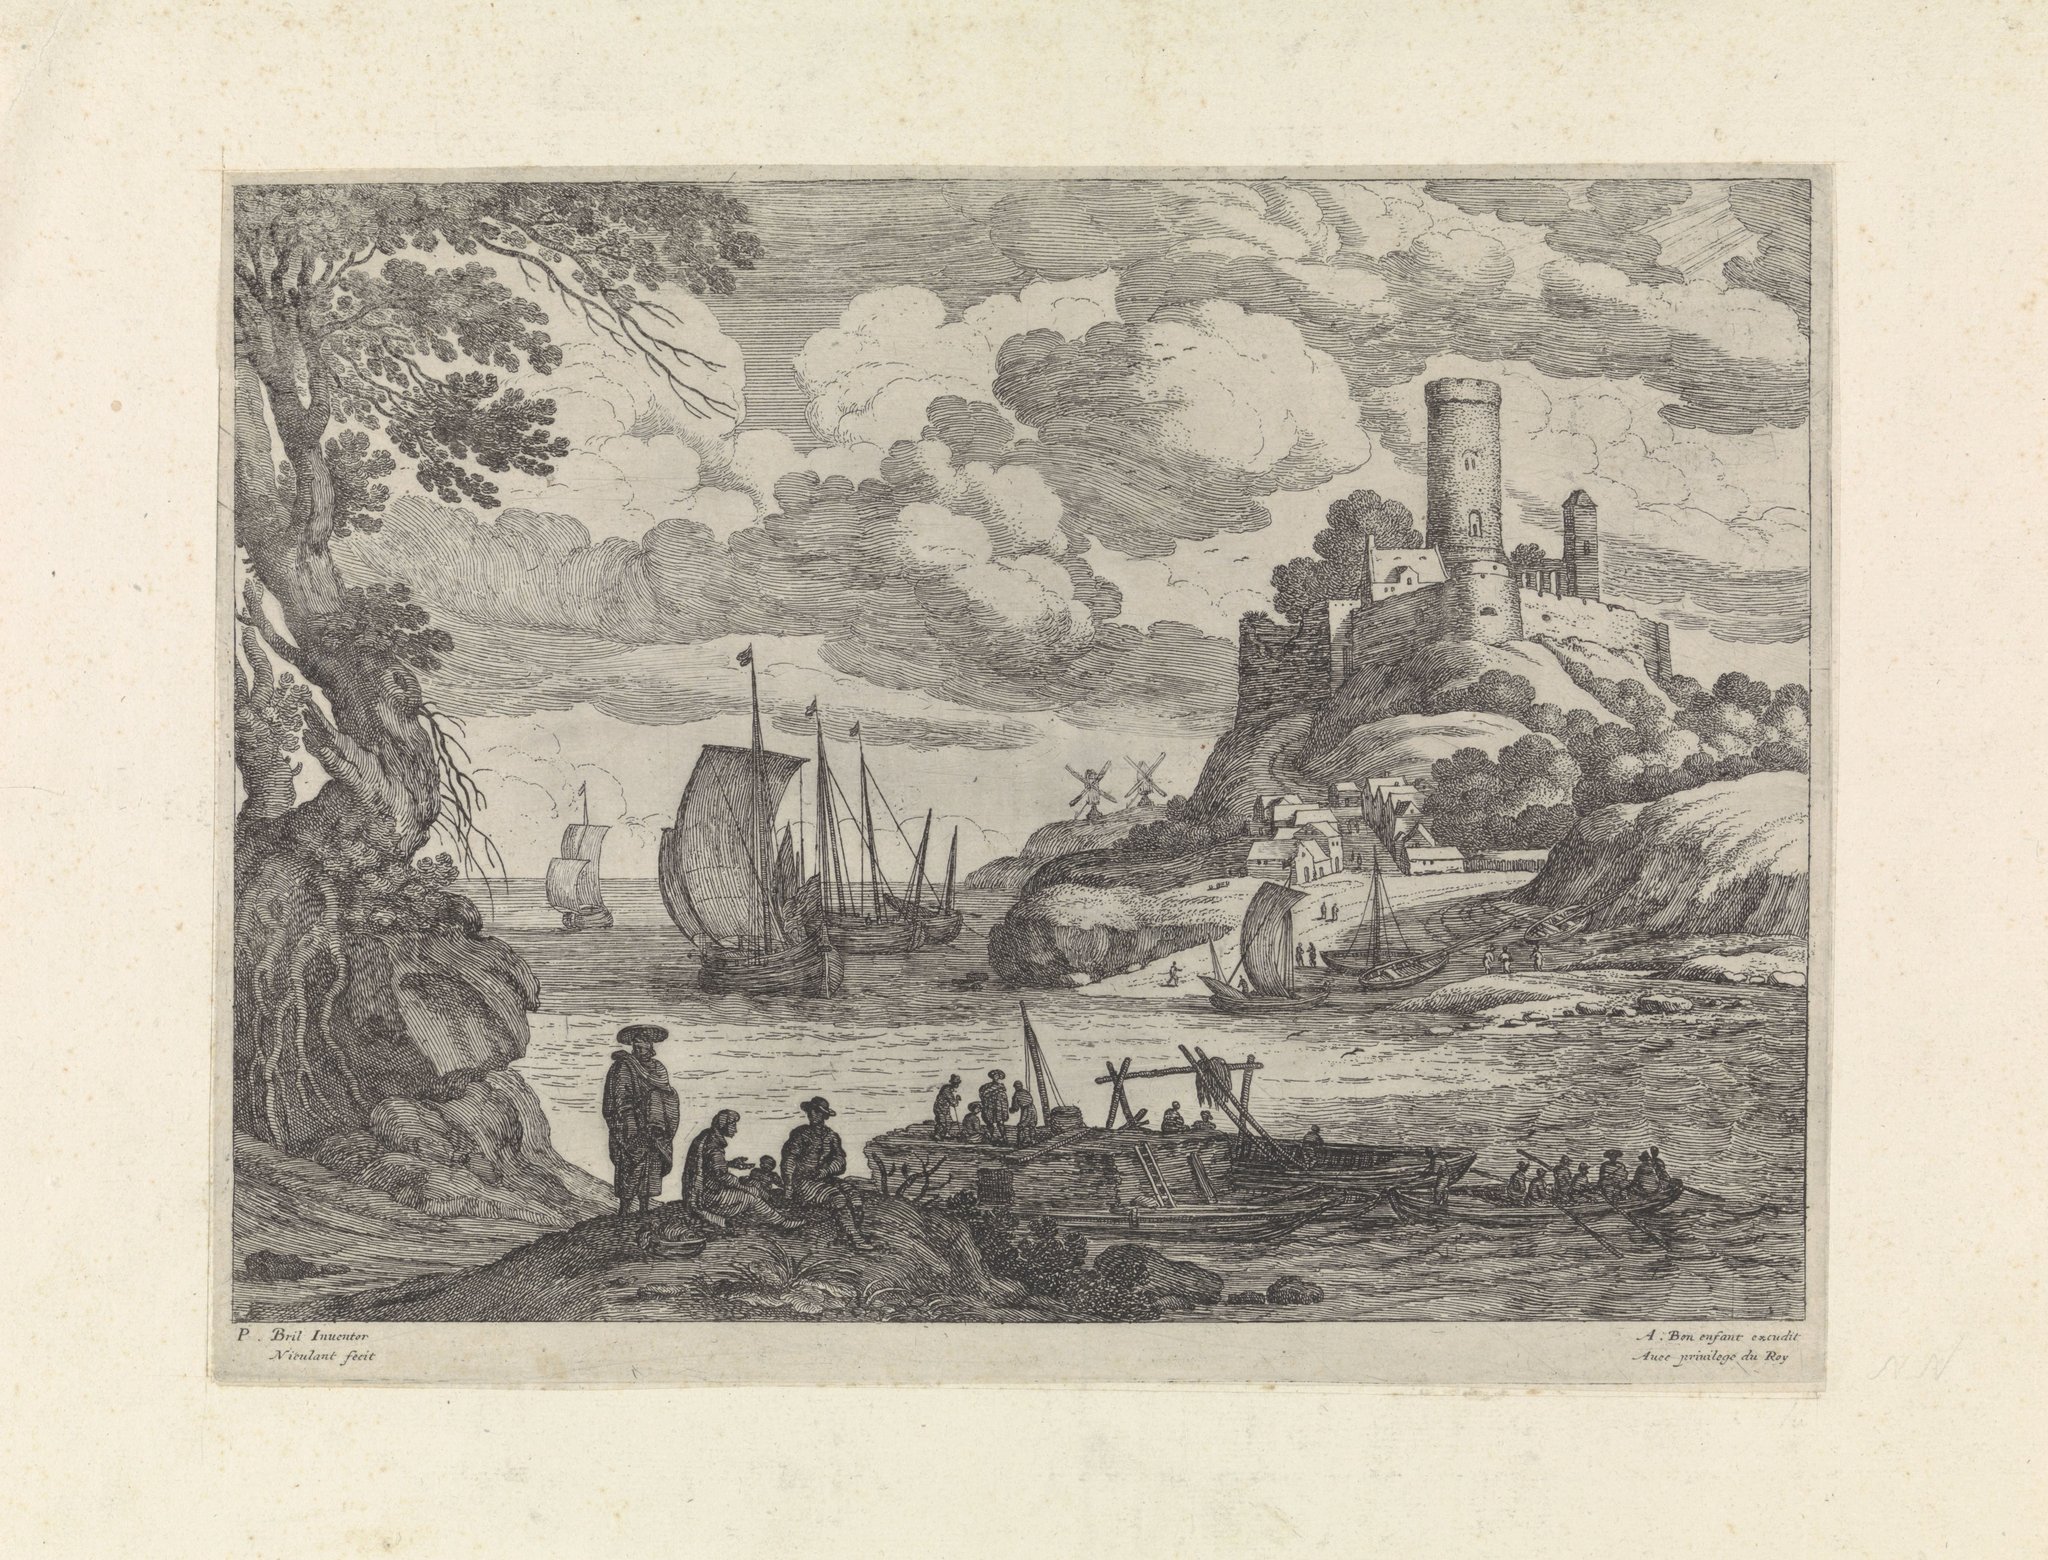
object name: print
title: Havengezicht met schepen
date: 1594-1635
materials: paper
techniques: etching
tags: harbour, fortress, sailing-ship, sailing-boat, rowing-boat, canoe, etc.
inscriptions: collector's mark: Lugt 2228, collector's mark: Lugt 2760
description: Verschillende schepen liggen voor anker in een riviermonding, die uitkomt op zee. Rechts aan de overzijde van het water ligt een burcht met een toren, met links daarvan twee windmolens. Op de voorgrond liggen een schip met lading en een roeiboot met bemanning.